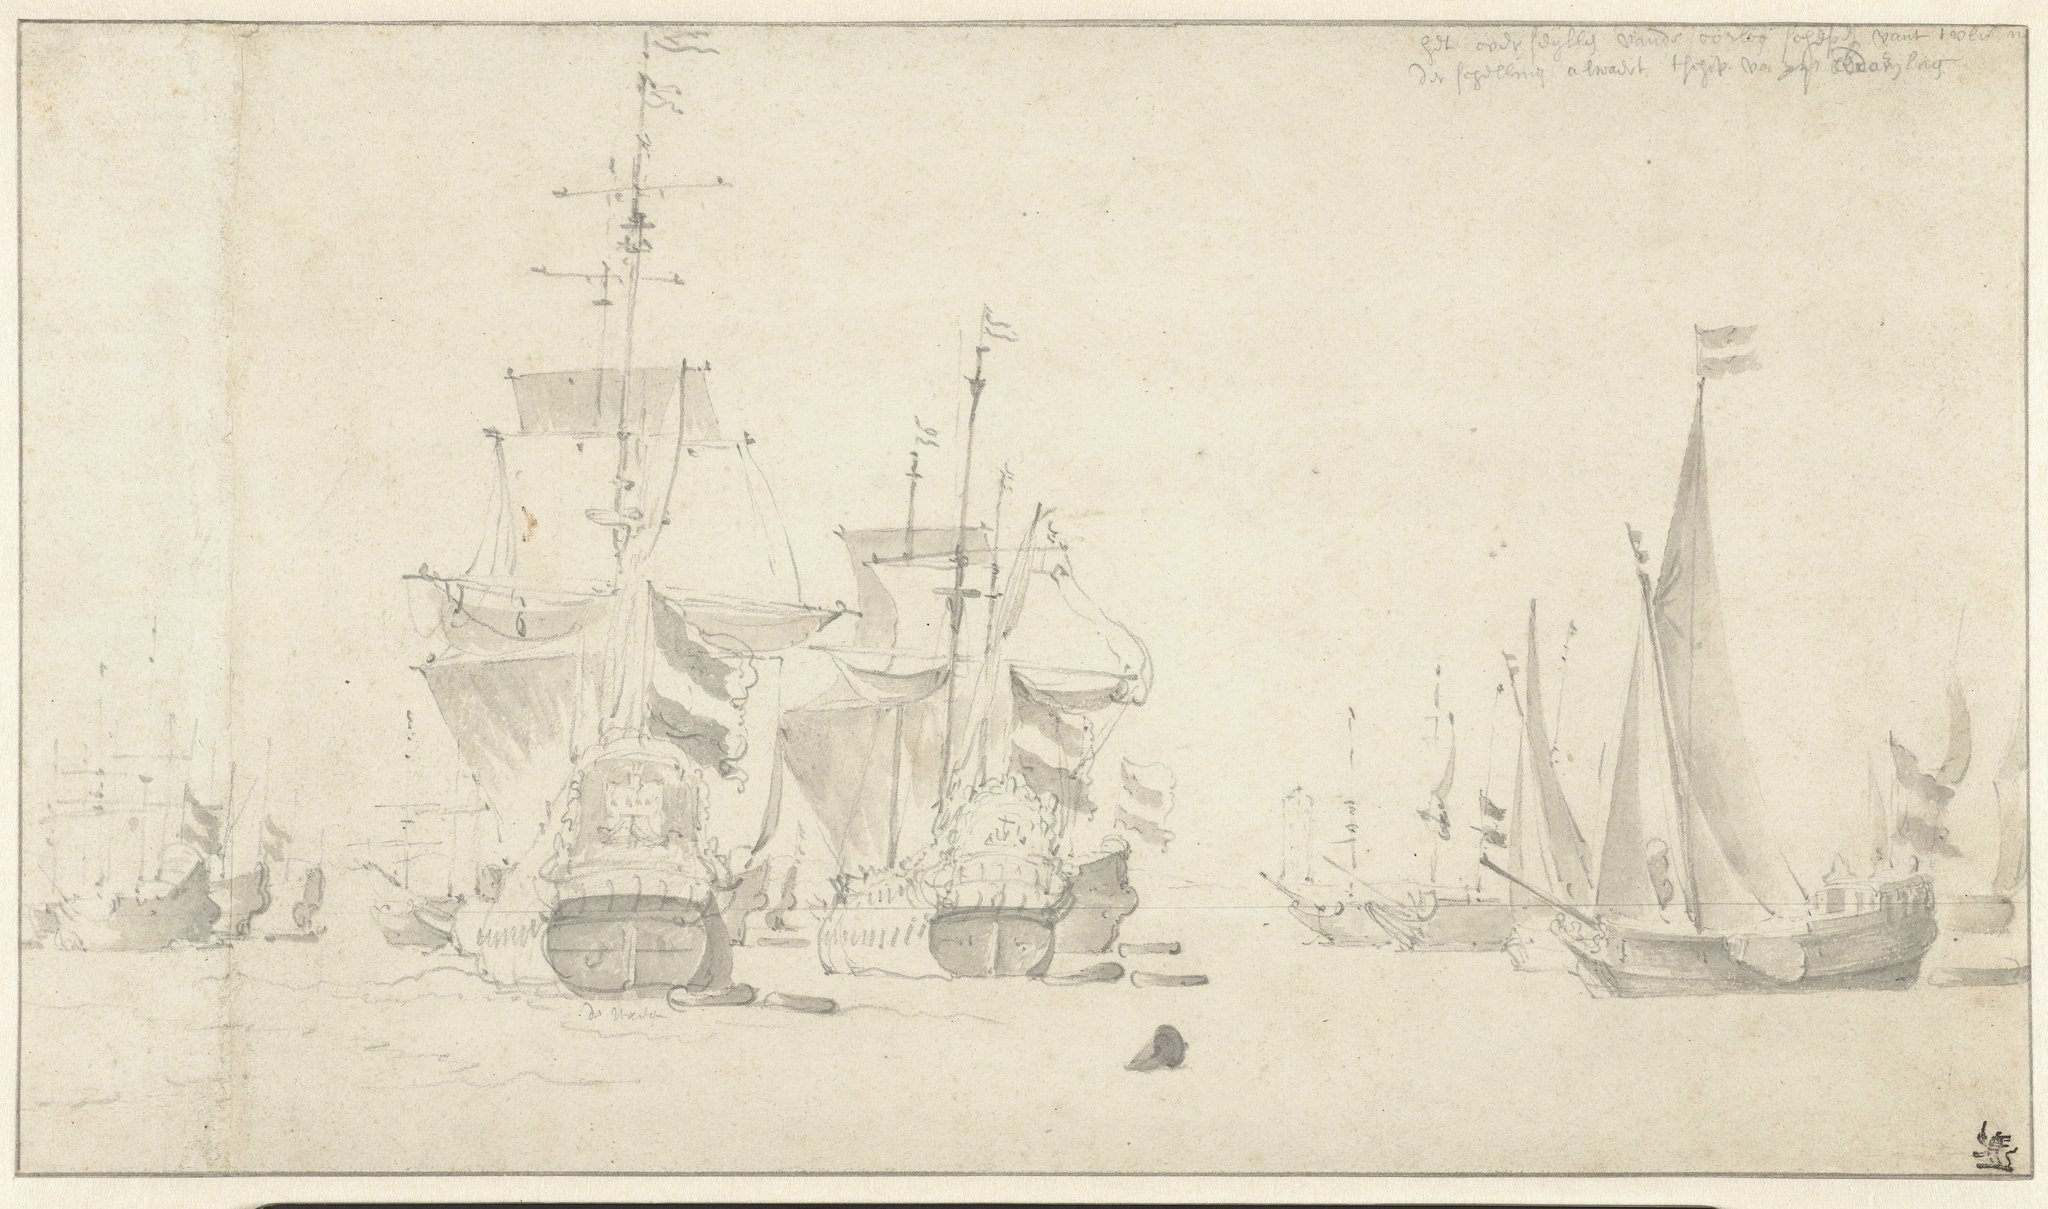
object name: drawing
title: het overseyllen vande oorlog schepen van 't vlie (...) der schelling alwaar tschip van zijn obdam lach.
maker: willem van de velde (ii)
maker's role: draughtsman, painter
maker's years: 1633-1707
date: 1643-1707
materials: paper, pencil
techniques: brush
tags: sailing-ship, sailing-boat, sea (seascape), army 'en route' (+ naval force), navy (+ sailing-ships)